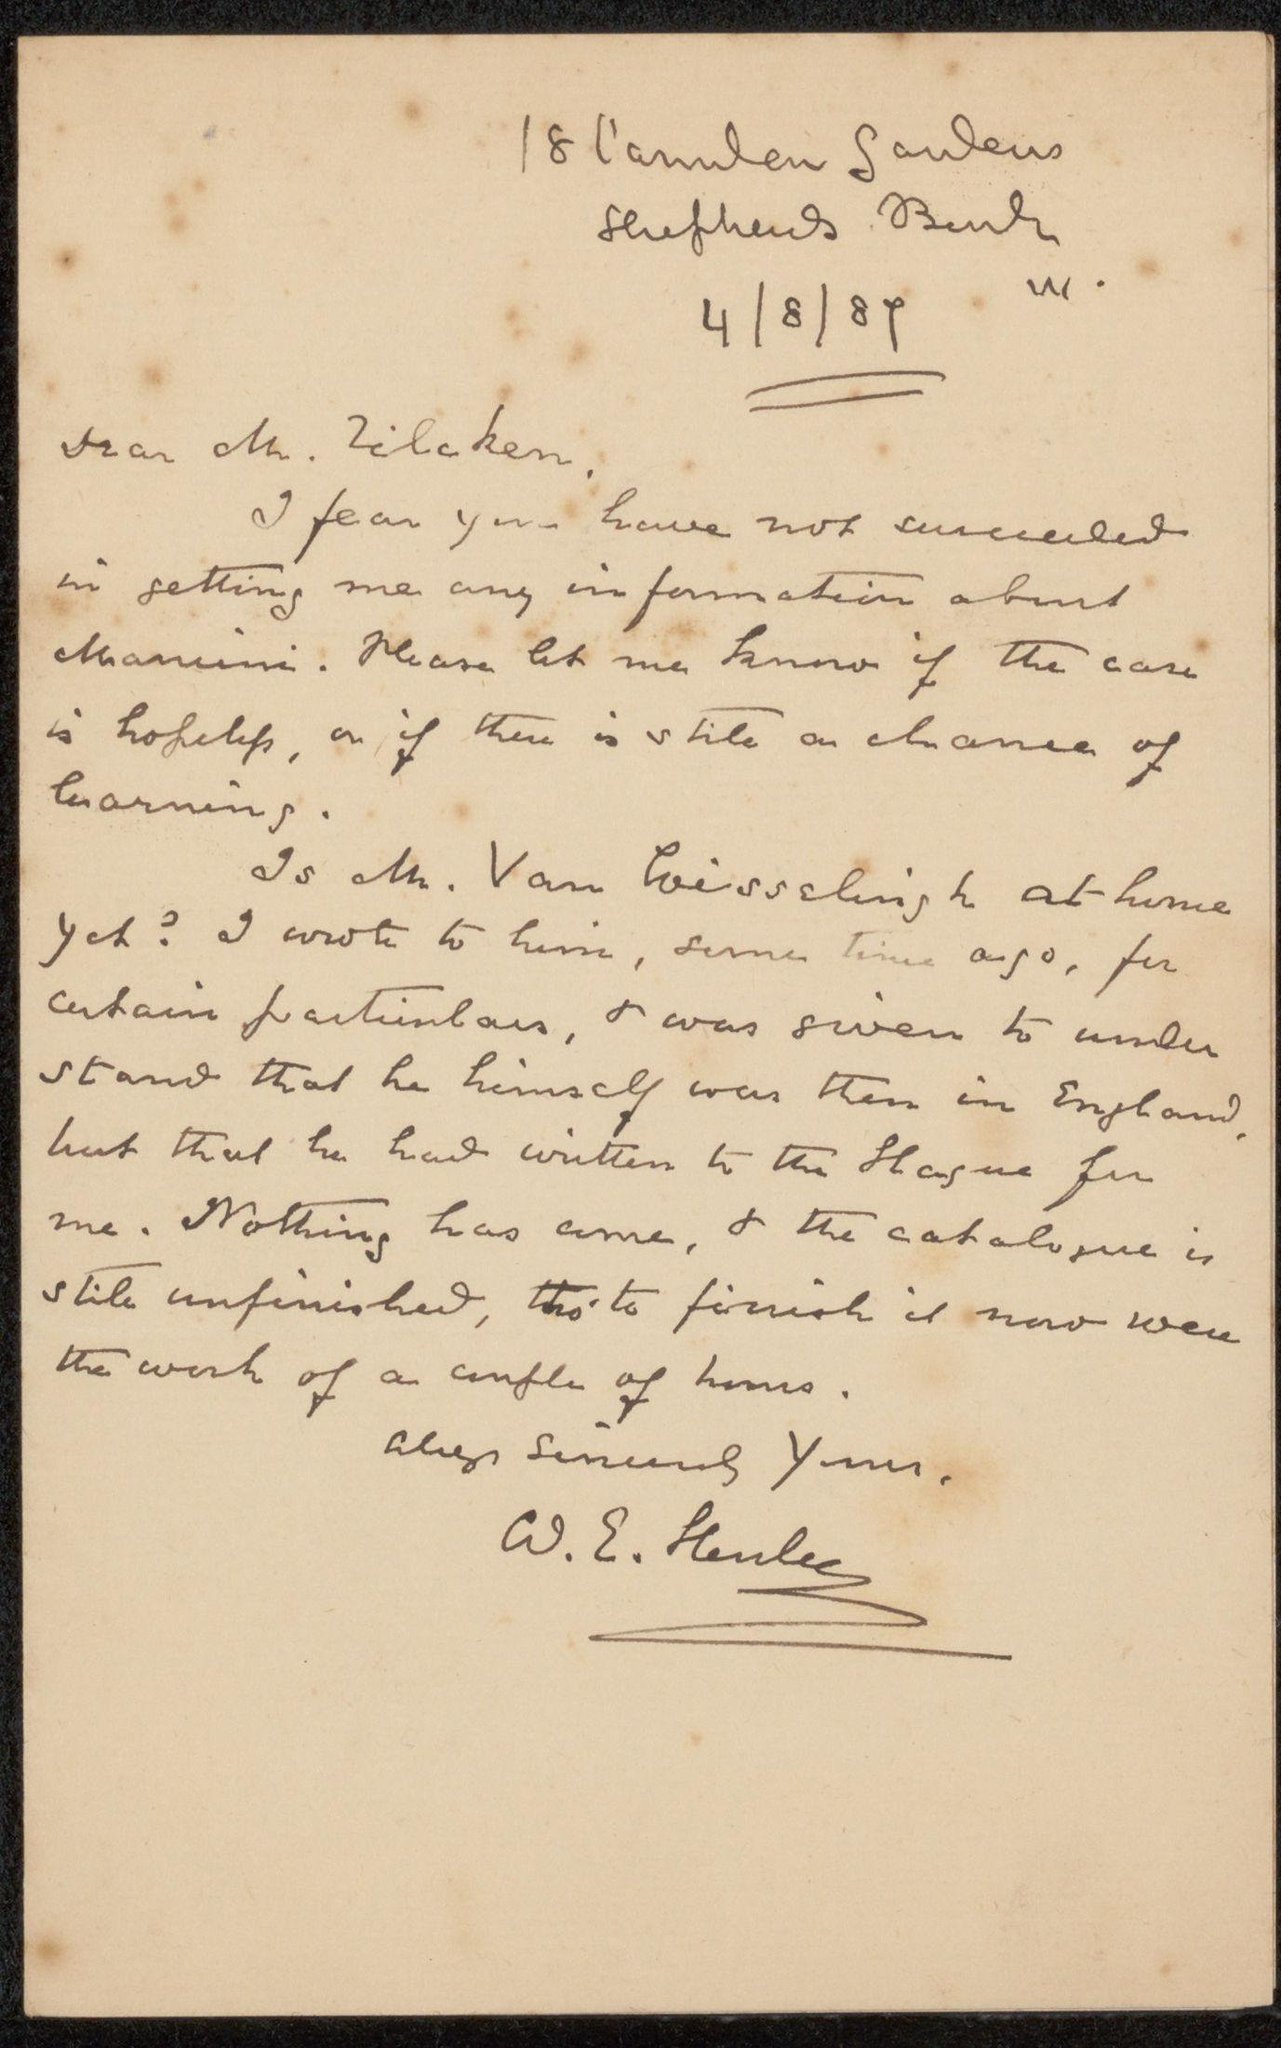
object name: letter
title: Brief aan Philip Zilcken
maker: william ernest henley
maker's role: criticus, dichter, redacteur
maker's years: 1849-1903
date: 1887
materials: ink, paper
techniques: pen, writing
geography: shepherd's bush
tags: elbert jan van wisselingh, painter, draughtsman, philip zilcken, printed matter, the hague, england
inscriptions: collector's mark: ‘RPK’